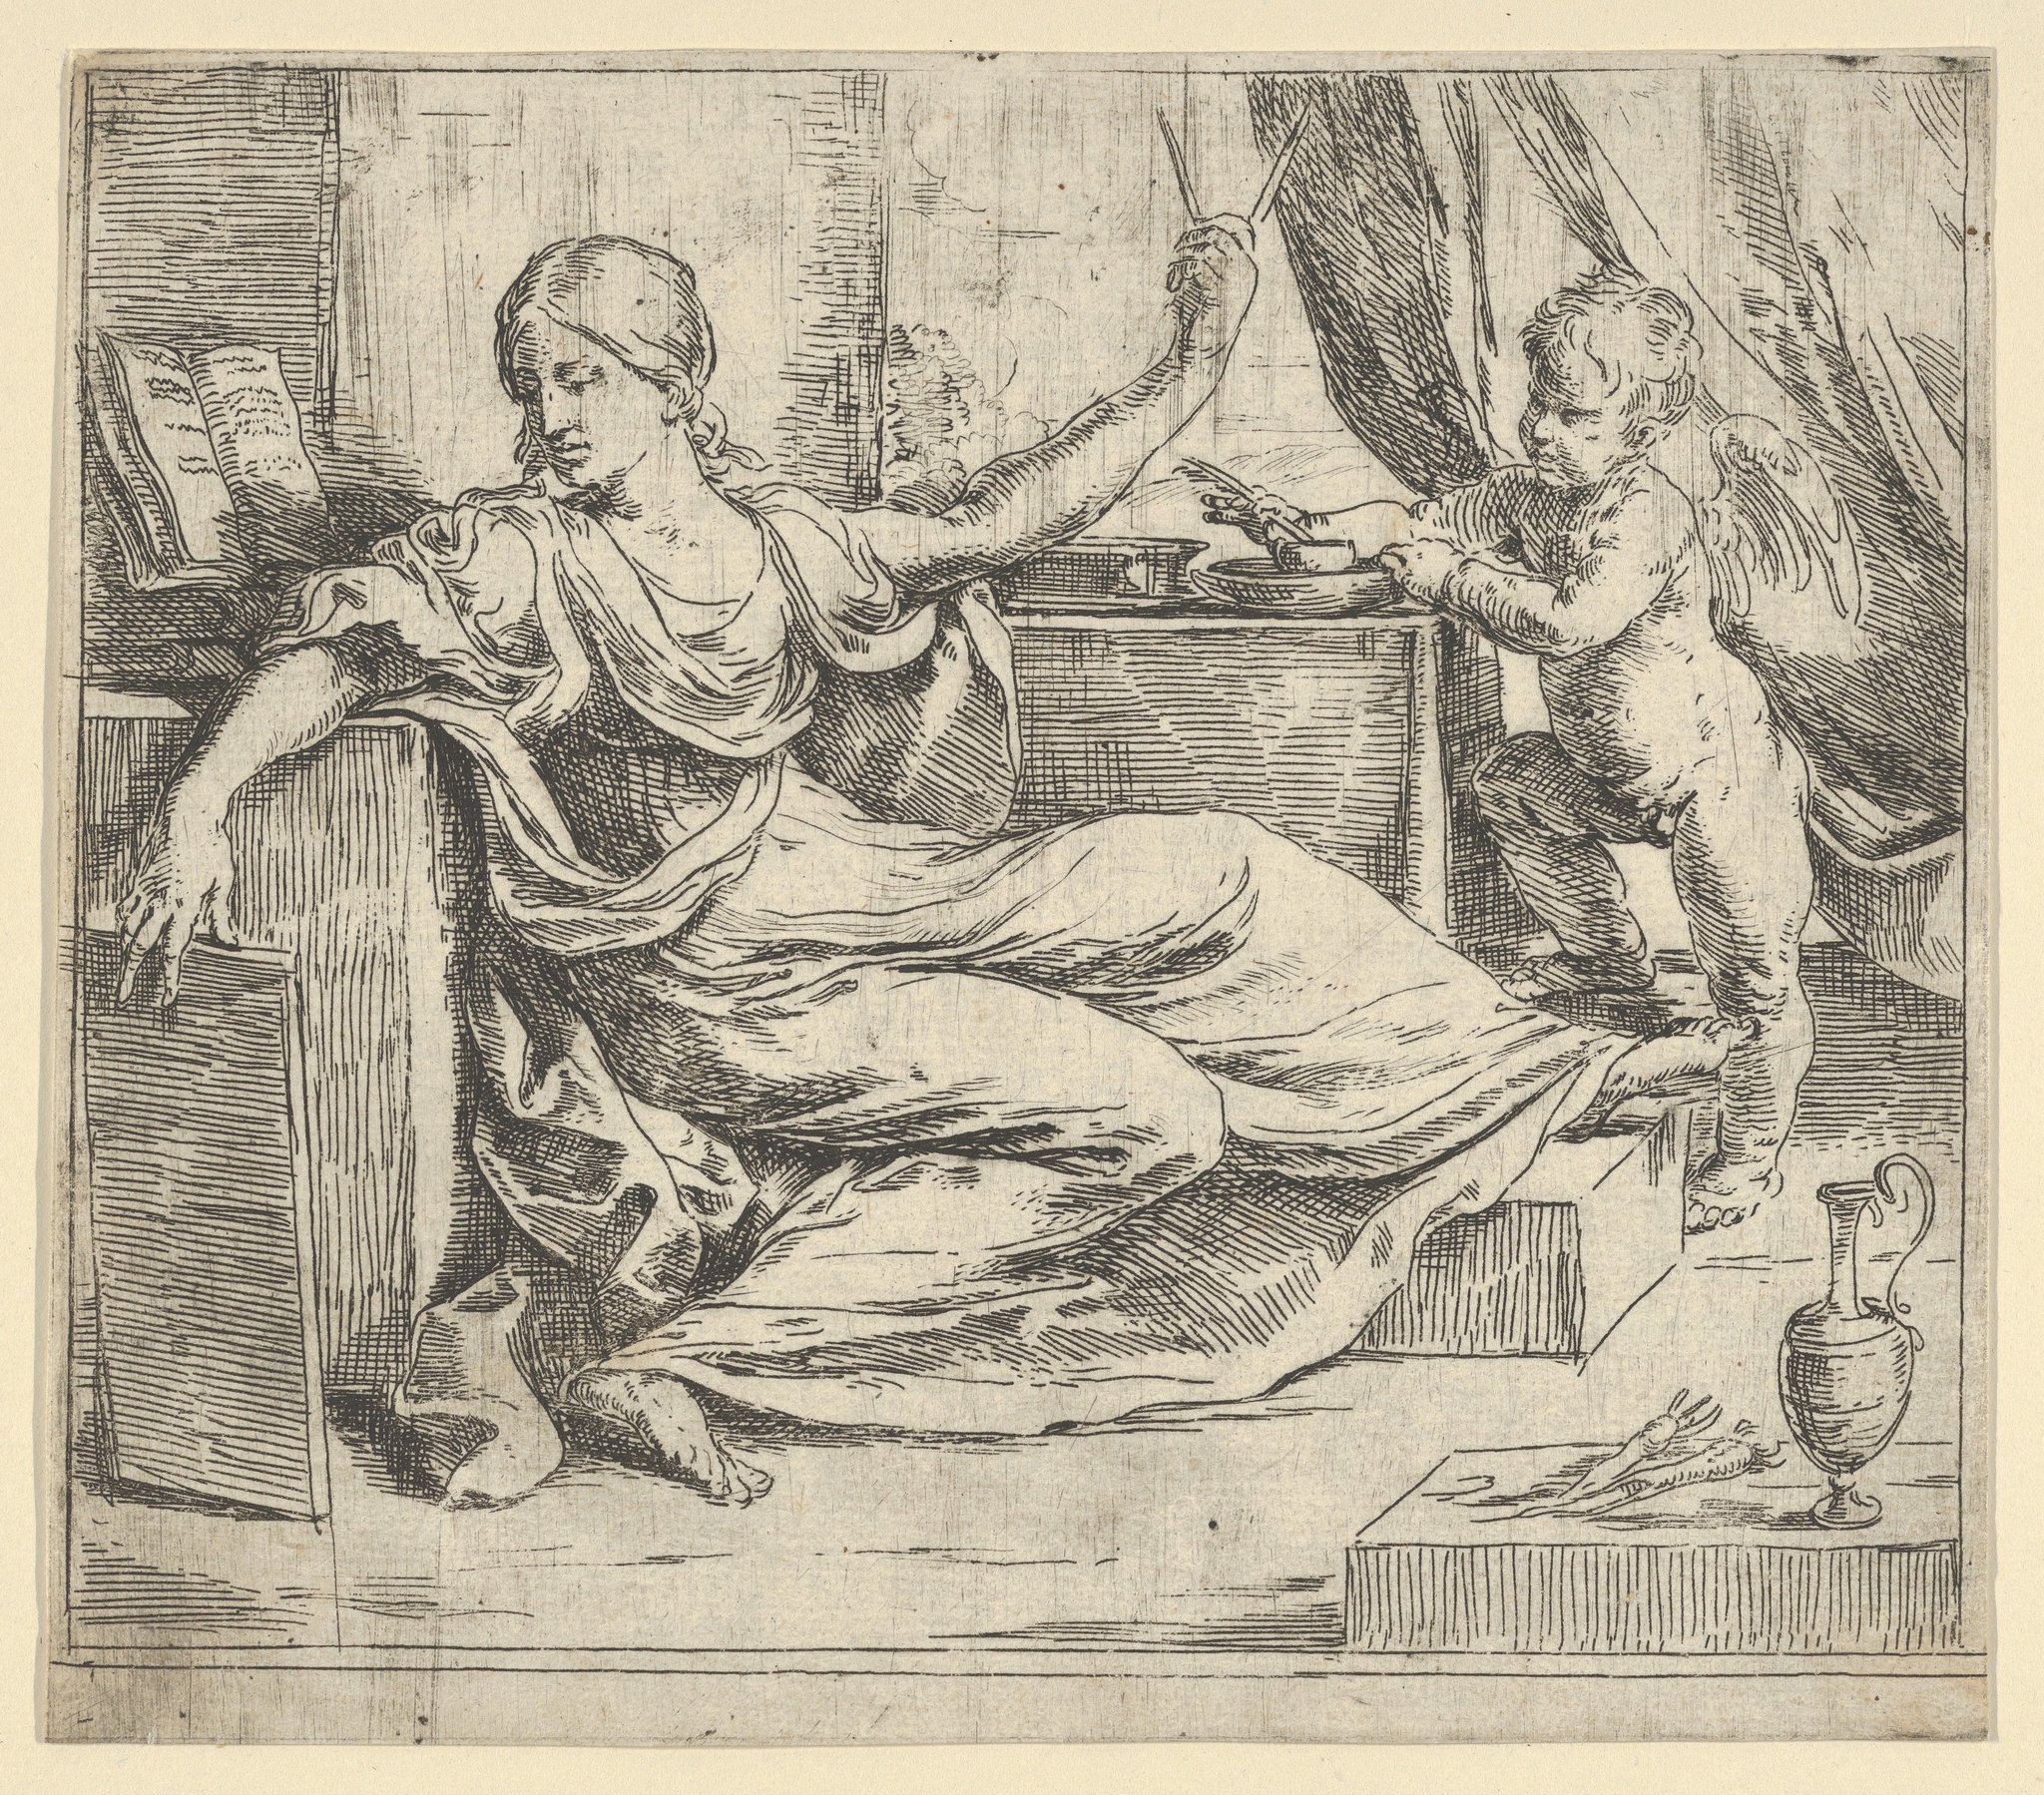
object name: print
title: Seated woman holding a tablet and compass (allegory of learning), a winged putto at right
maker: guido reni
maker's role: artist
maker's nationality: italian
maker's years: 1575-1642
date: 1600-1640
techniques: etching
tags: tablets,women